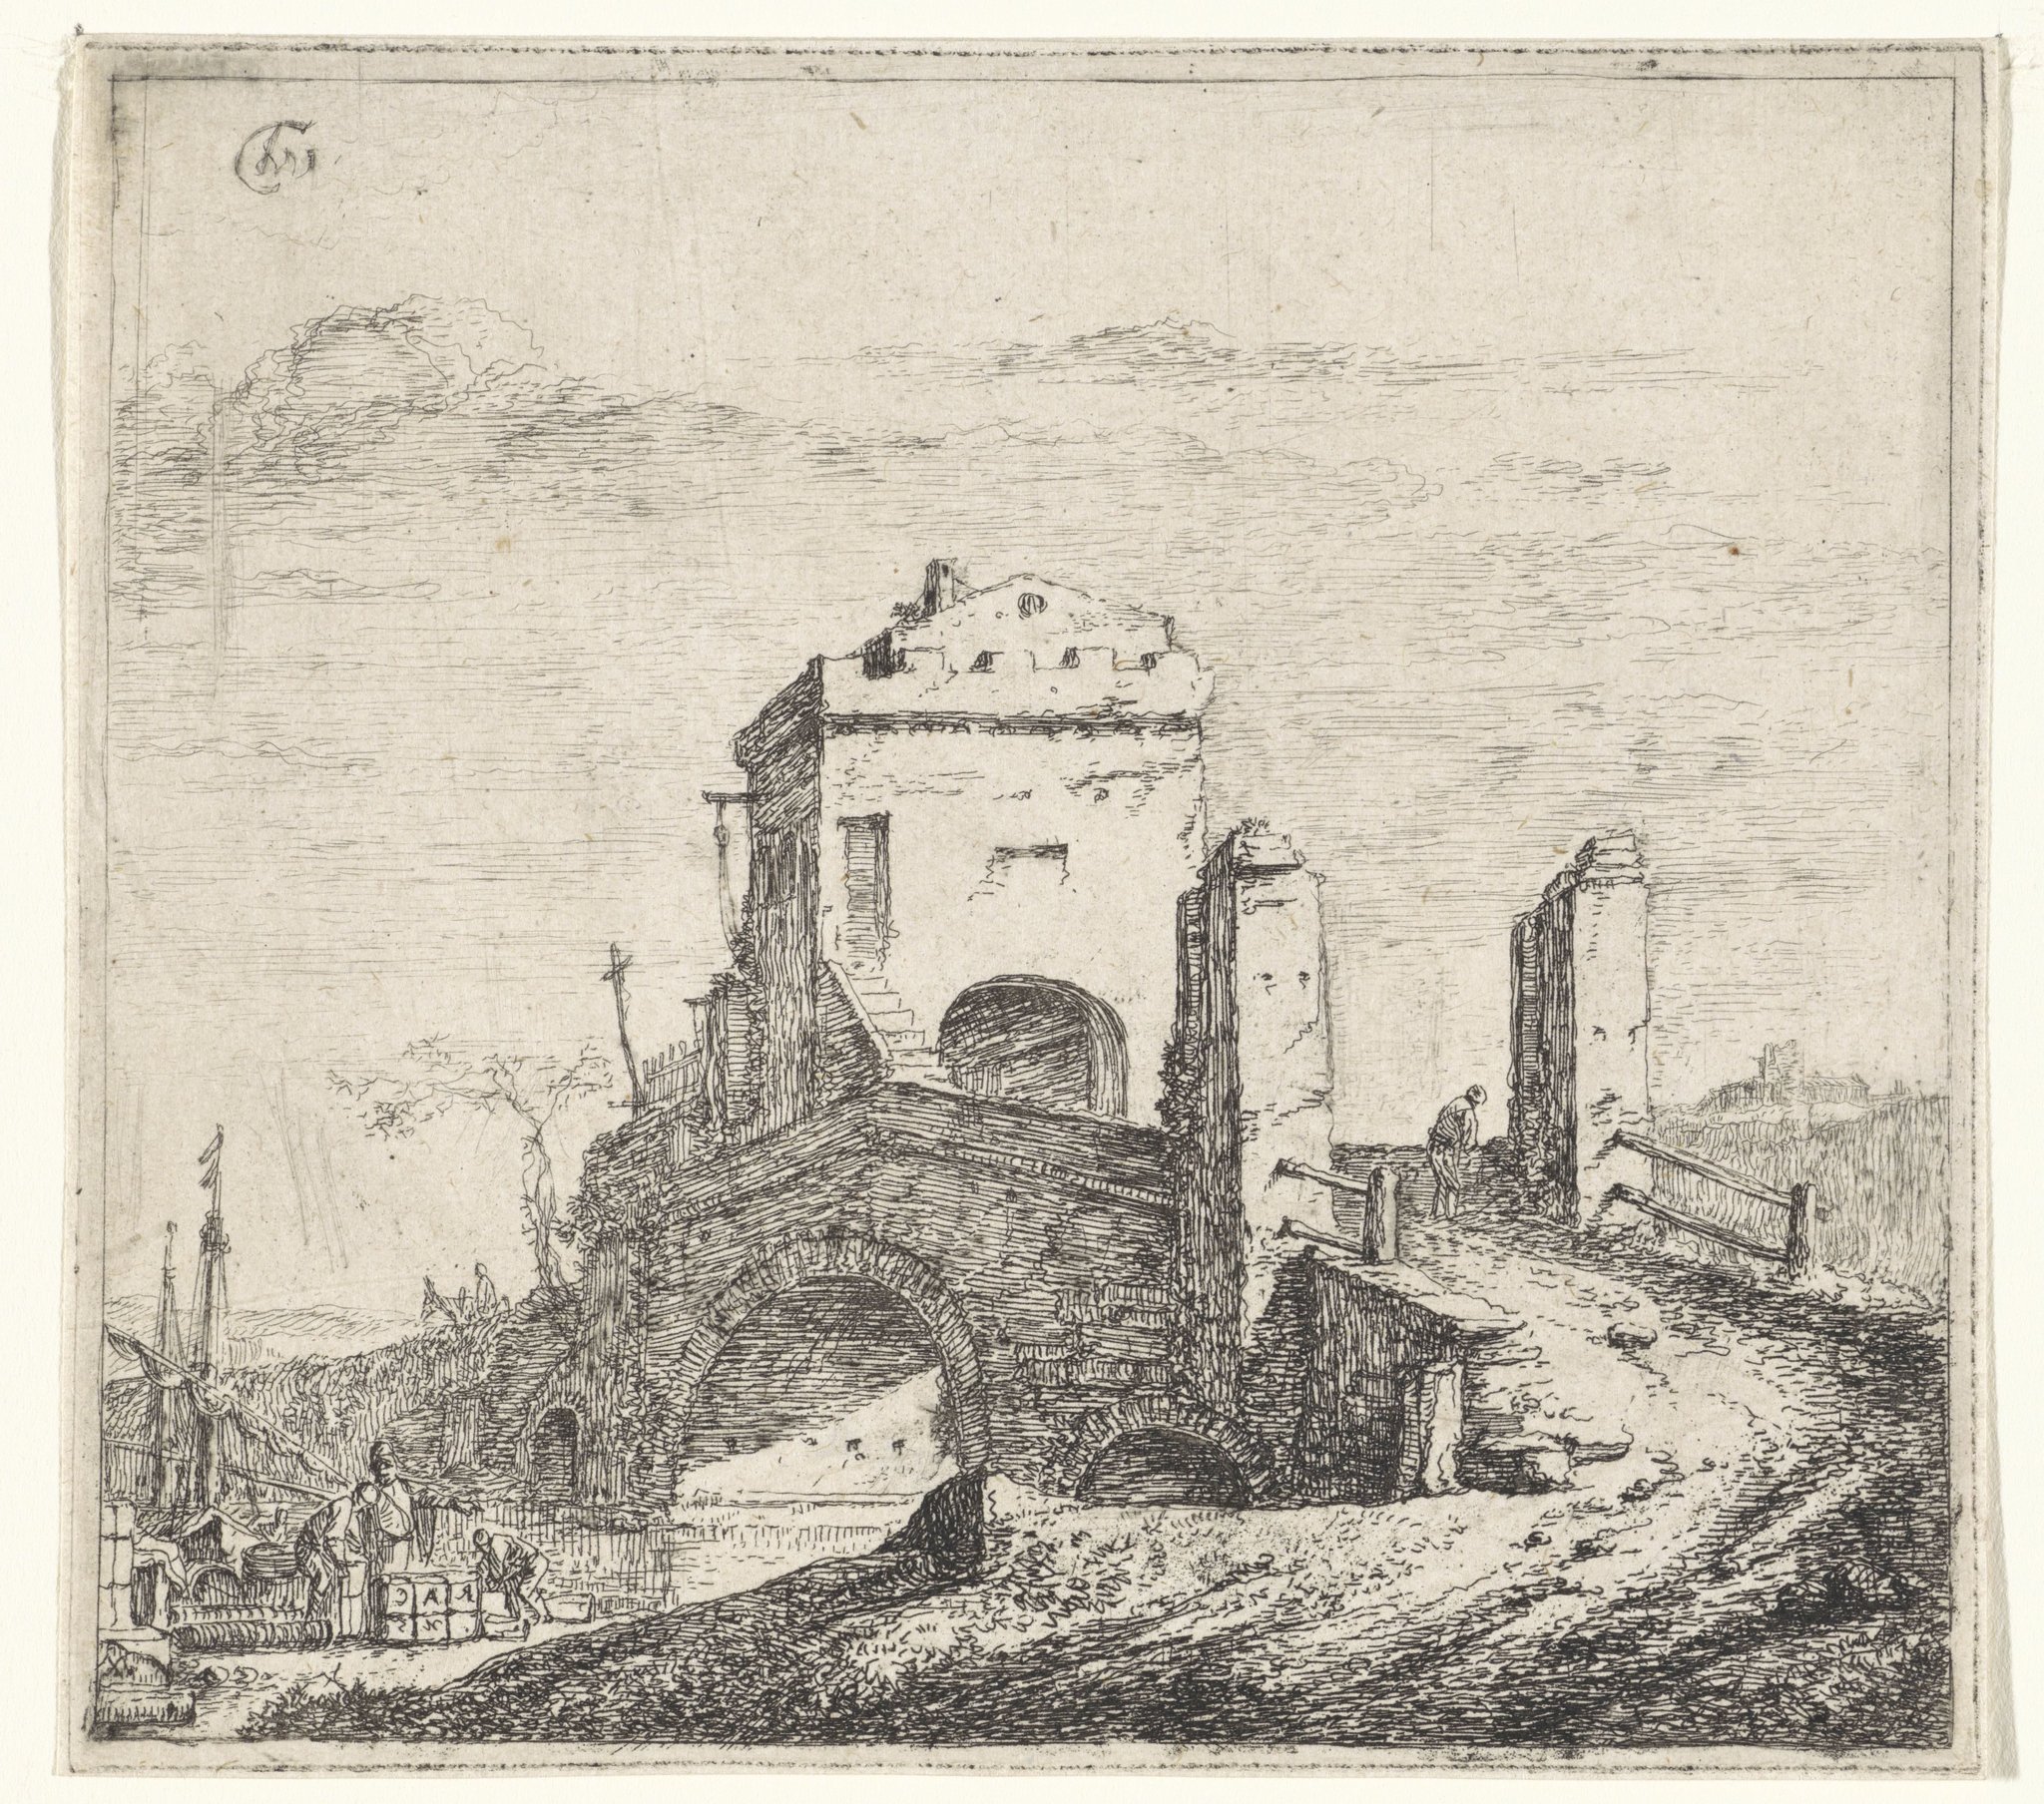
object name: print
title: Gezicht op een brug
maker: thomas wijck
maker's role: draughtsman, painter, print maker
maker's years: 1616-1677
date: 1626-1677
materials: paper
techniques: etching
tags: bridge, merchant, salesman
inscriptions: collector's mark: Lugt 240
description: Een man staat op de brug. Onder de brug op de kade drie koopmannen tussen koopwaar.